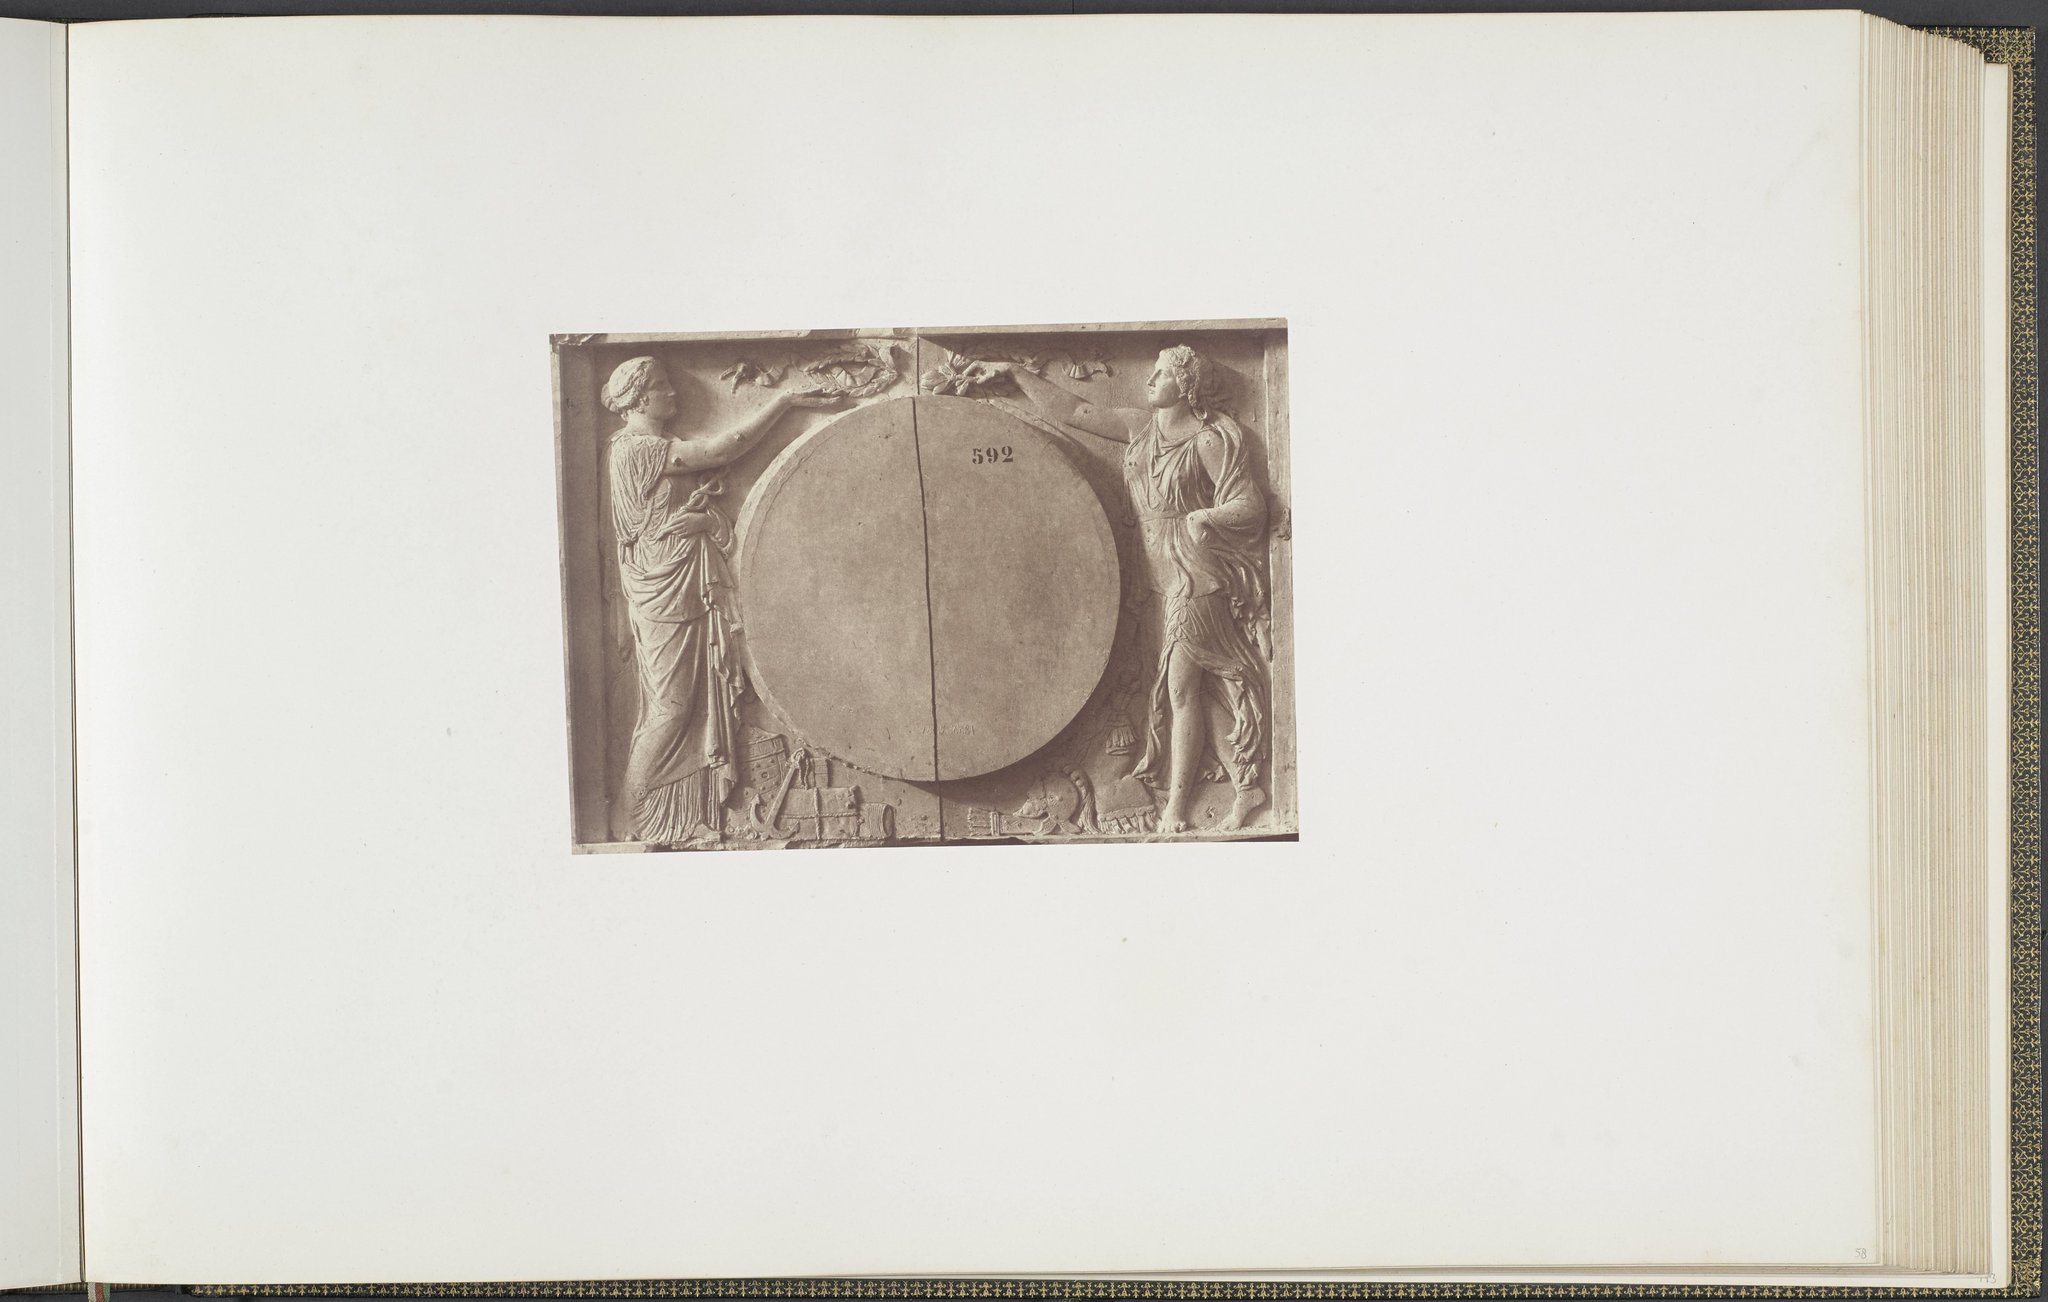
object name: photograph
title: Gipsmodel voor beeldhouwwerk op het Palais du Louvre: "Le Commerce et la Paix" door Romain Boitel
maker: édouard denis baldus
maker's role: fotograaf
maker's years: 1813-1889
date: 1855-1857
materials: paper, photographic support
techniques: salted paper print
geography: paris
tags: piece of sculpture, reproduction of a piece of sculpture, permanent exhibition, museum, paris, tuileries palace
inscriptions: number: ‘592’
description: Onderdeel van Réunion des Tuileries au Louvre 1852-1857, album 1.